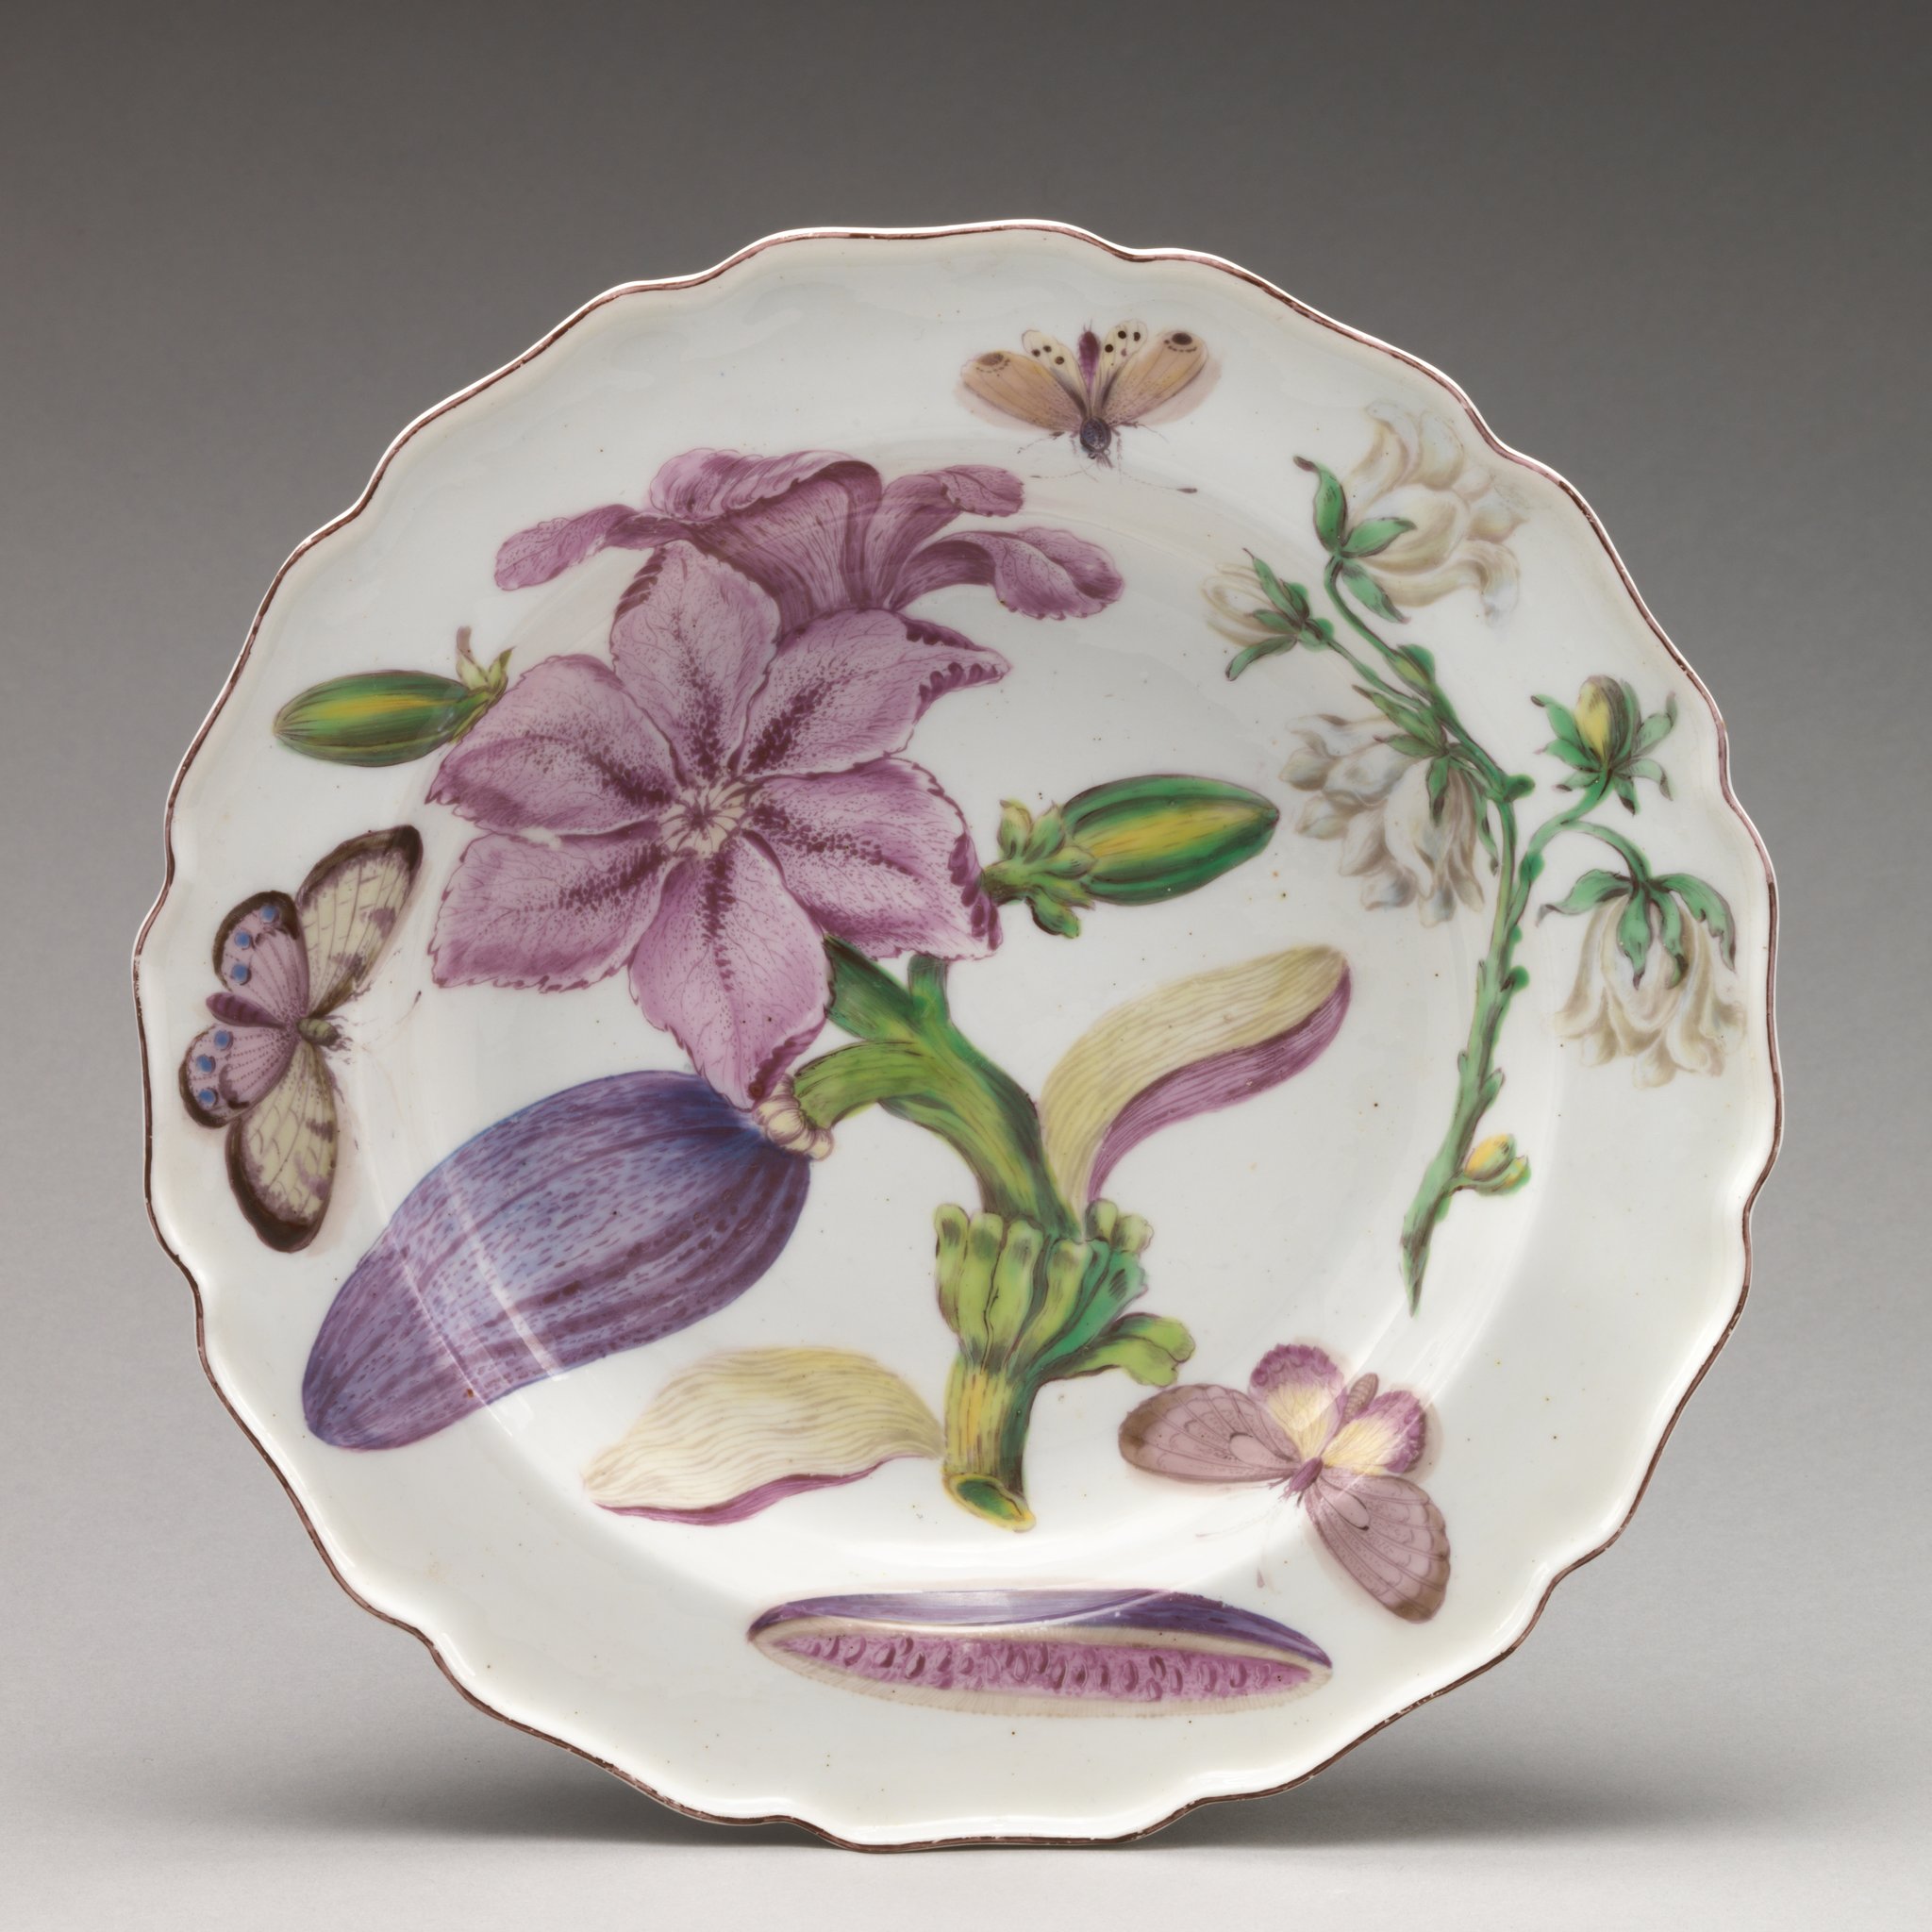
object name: dessert plate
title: Botanical plate with a flowering eggplant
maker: chelsea porcelain manufactory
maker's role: factory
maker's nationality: british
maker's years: 1744-1784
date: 1755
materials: enamel, soft paste porcelain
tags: eggplants,butterflies